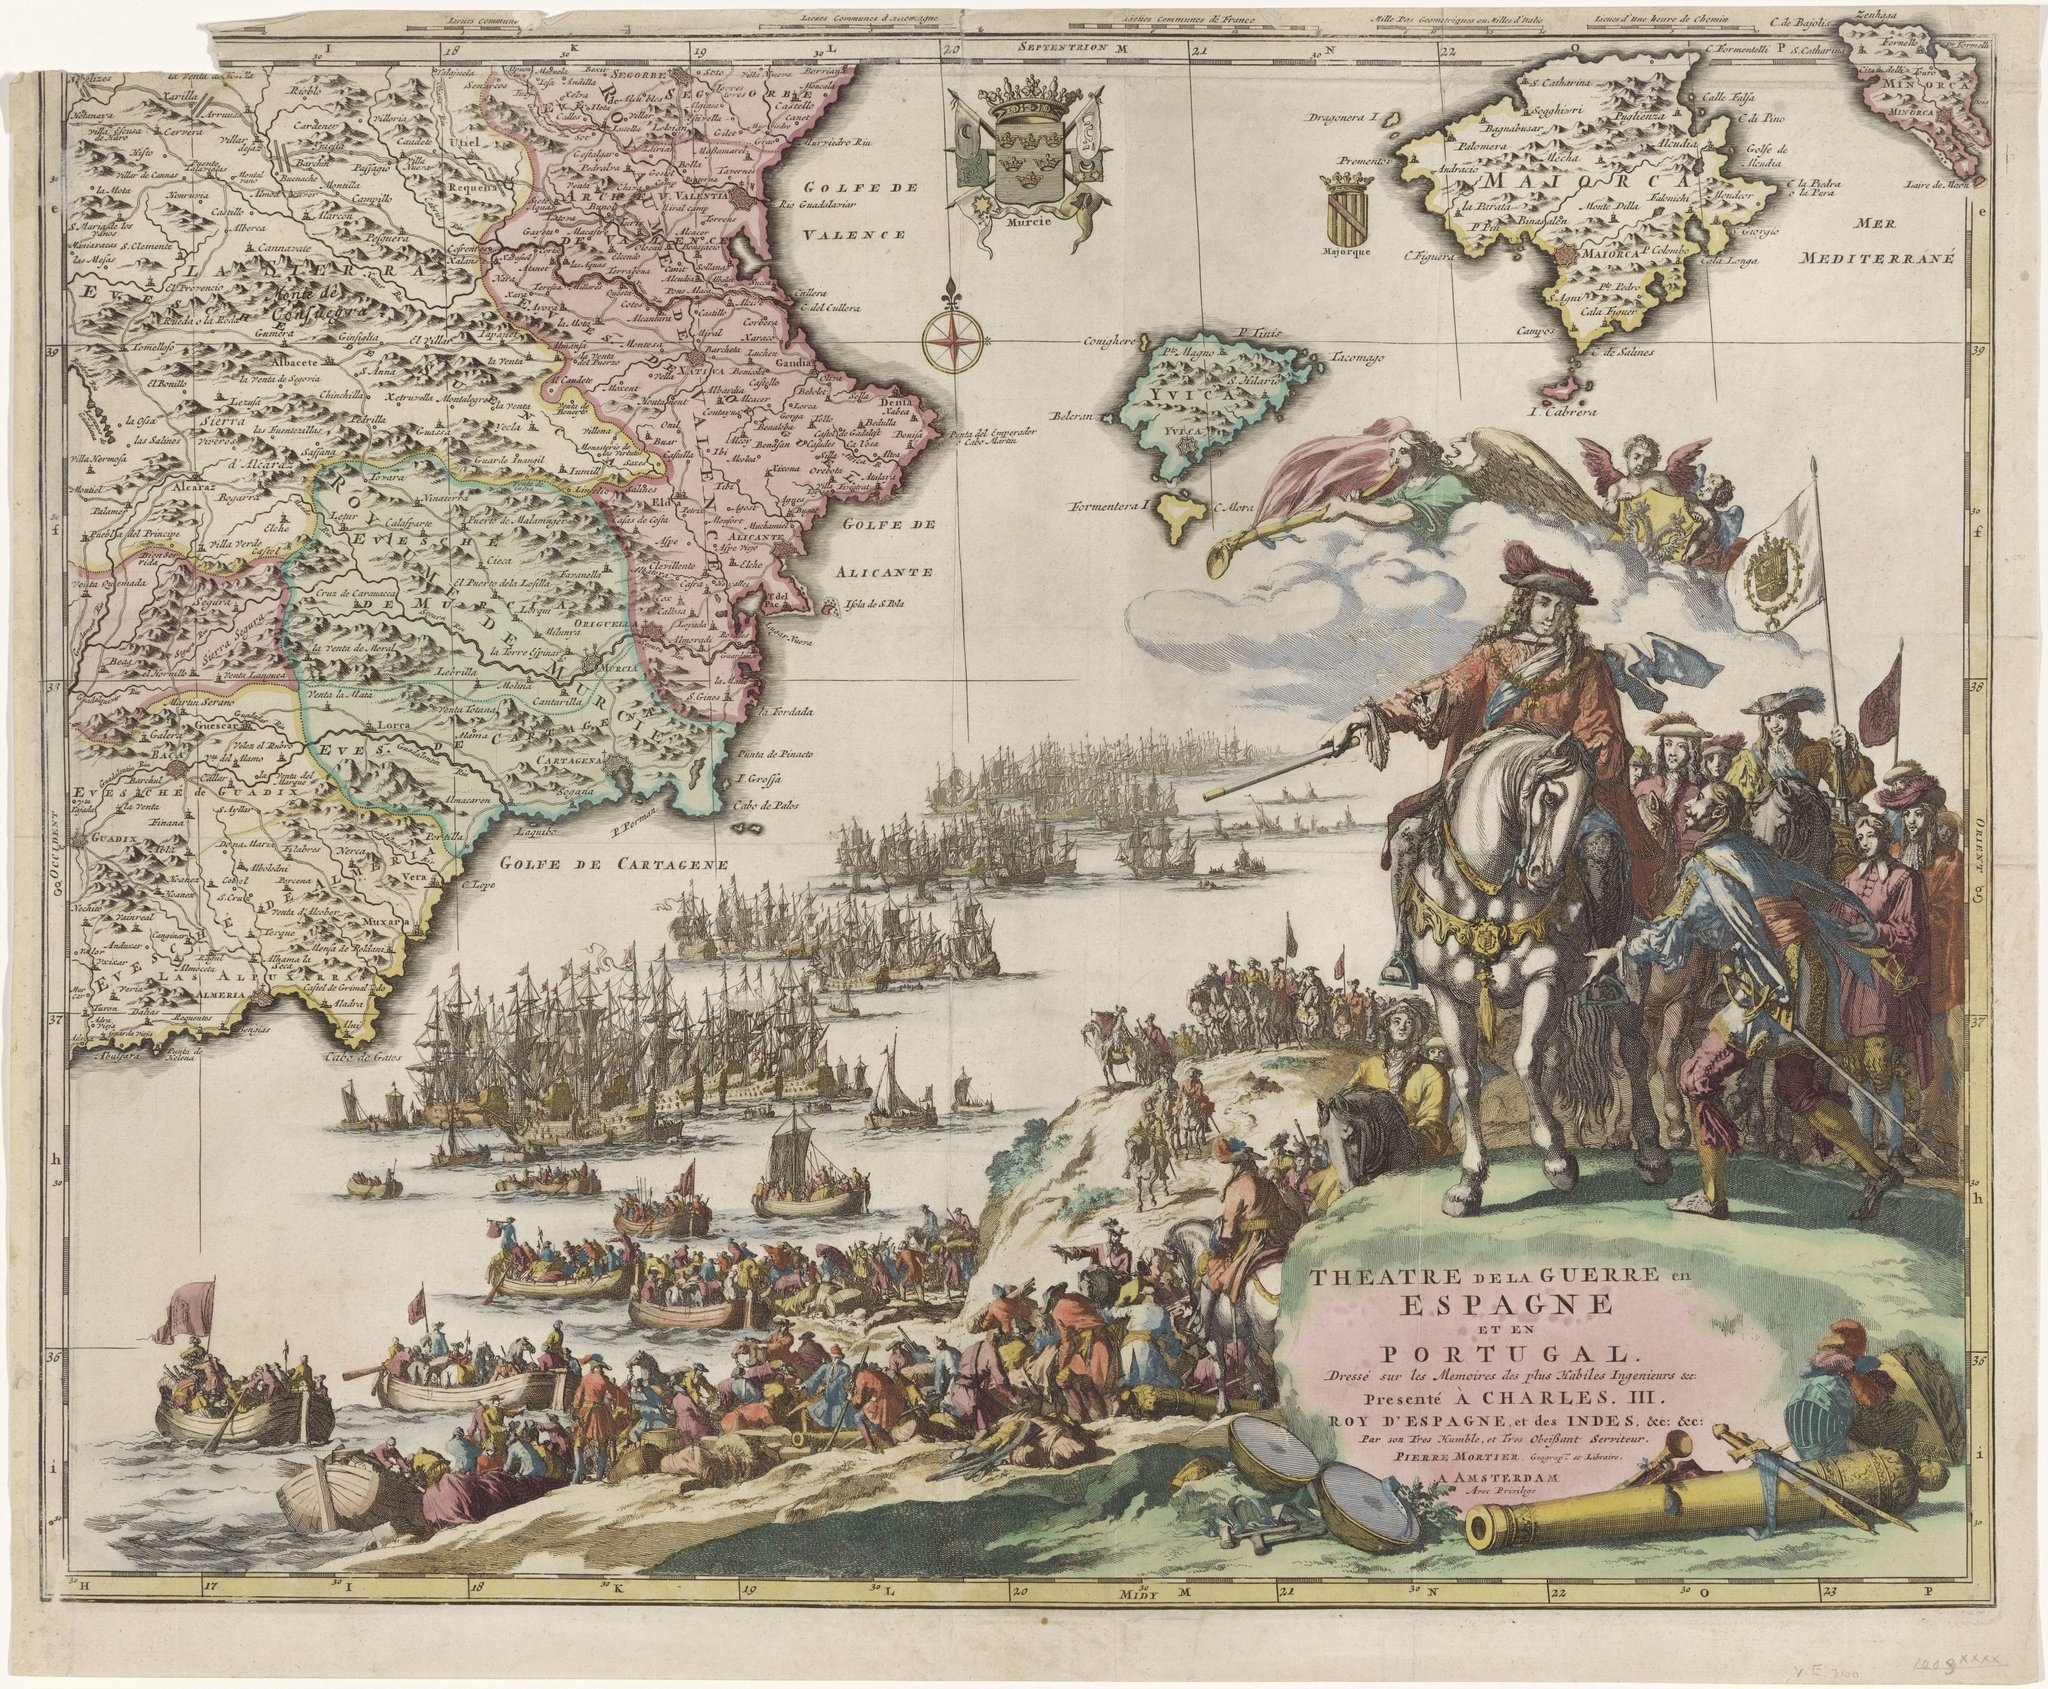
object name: print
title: Kaart van Spanje en Portugal, ca. 1703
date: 1703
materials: paper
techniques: engraving, etching, hand coloring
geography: amsterdam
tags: vienna, charles vi (holy roman emperor), maps of separate countries or regions, warfare; military affairs (+ landing, disembarkation of armed forces), spain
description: Kaart met een deel van de Spaanse oost- en zuidkust. Onderdeel (blad rechtsonder) van een grote kaart van Spanje en Portugal in vier bladen, ca. 1703. Vignet met koning Karel III te paard met zijn gevolg, voor hem een Spanjaard. Links de landing van Geallieerde troepen in Spanje. In de wolken blaast Faam op haar bazuin.